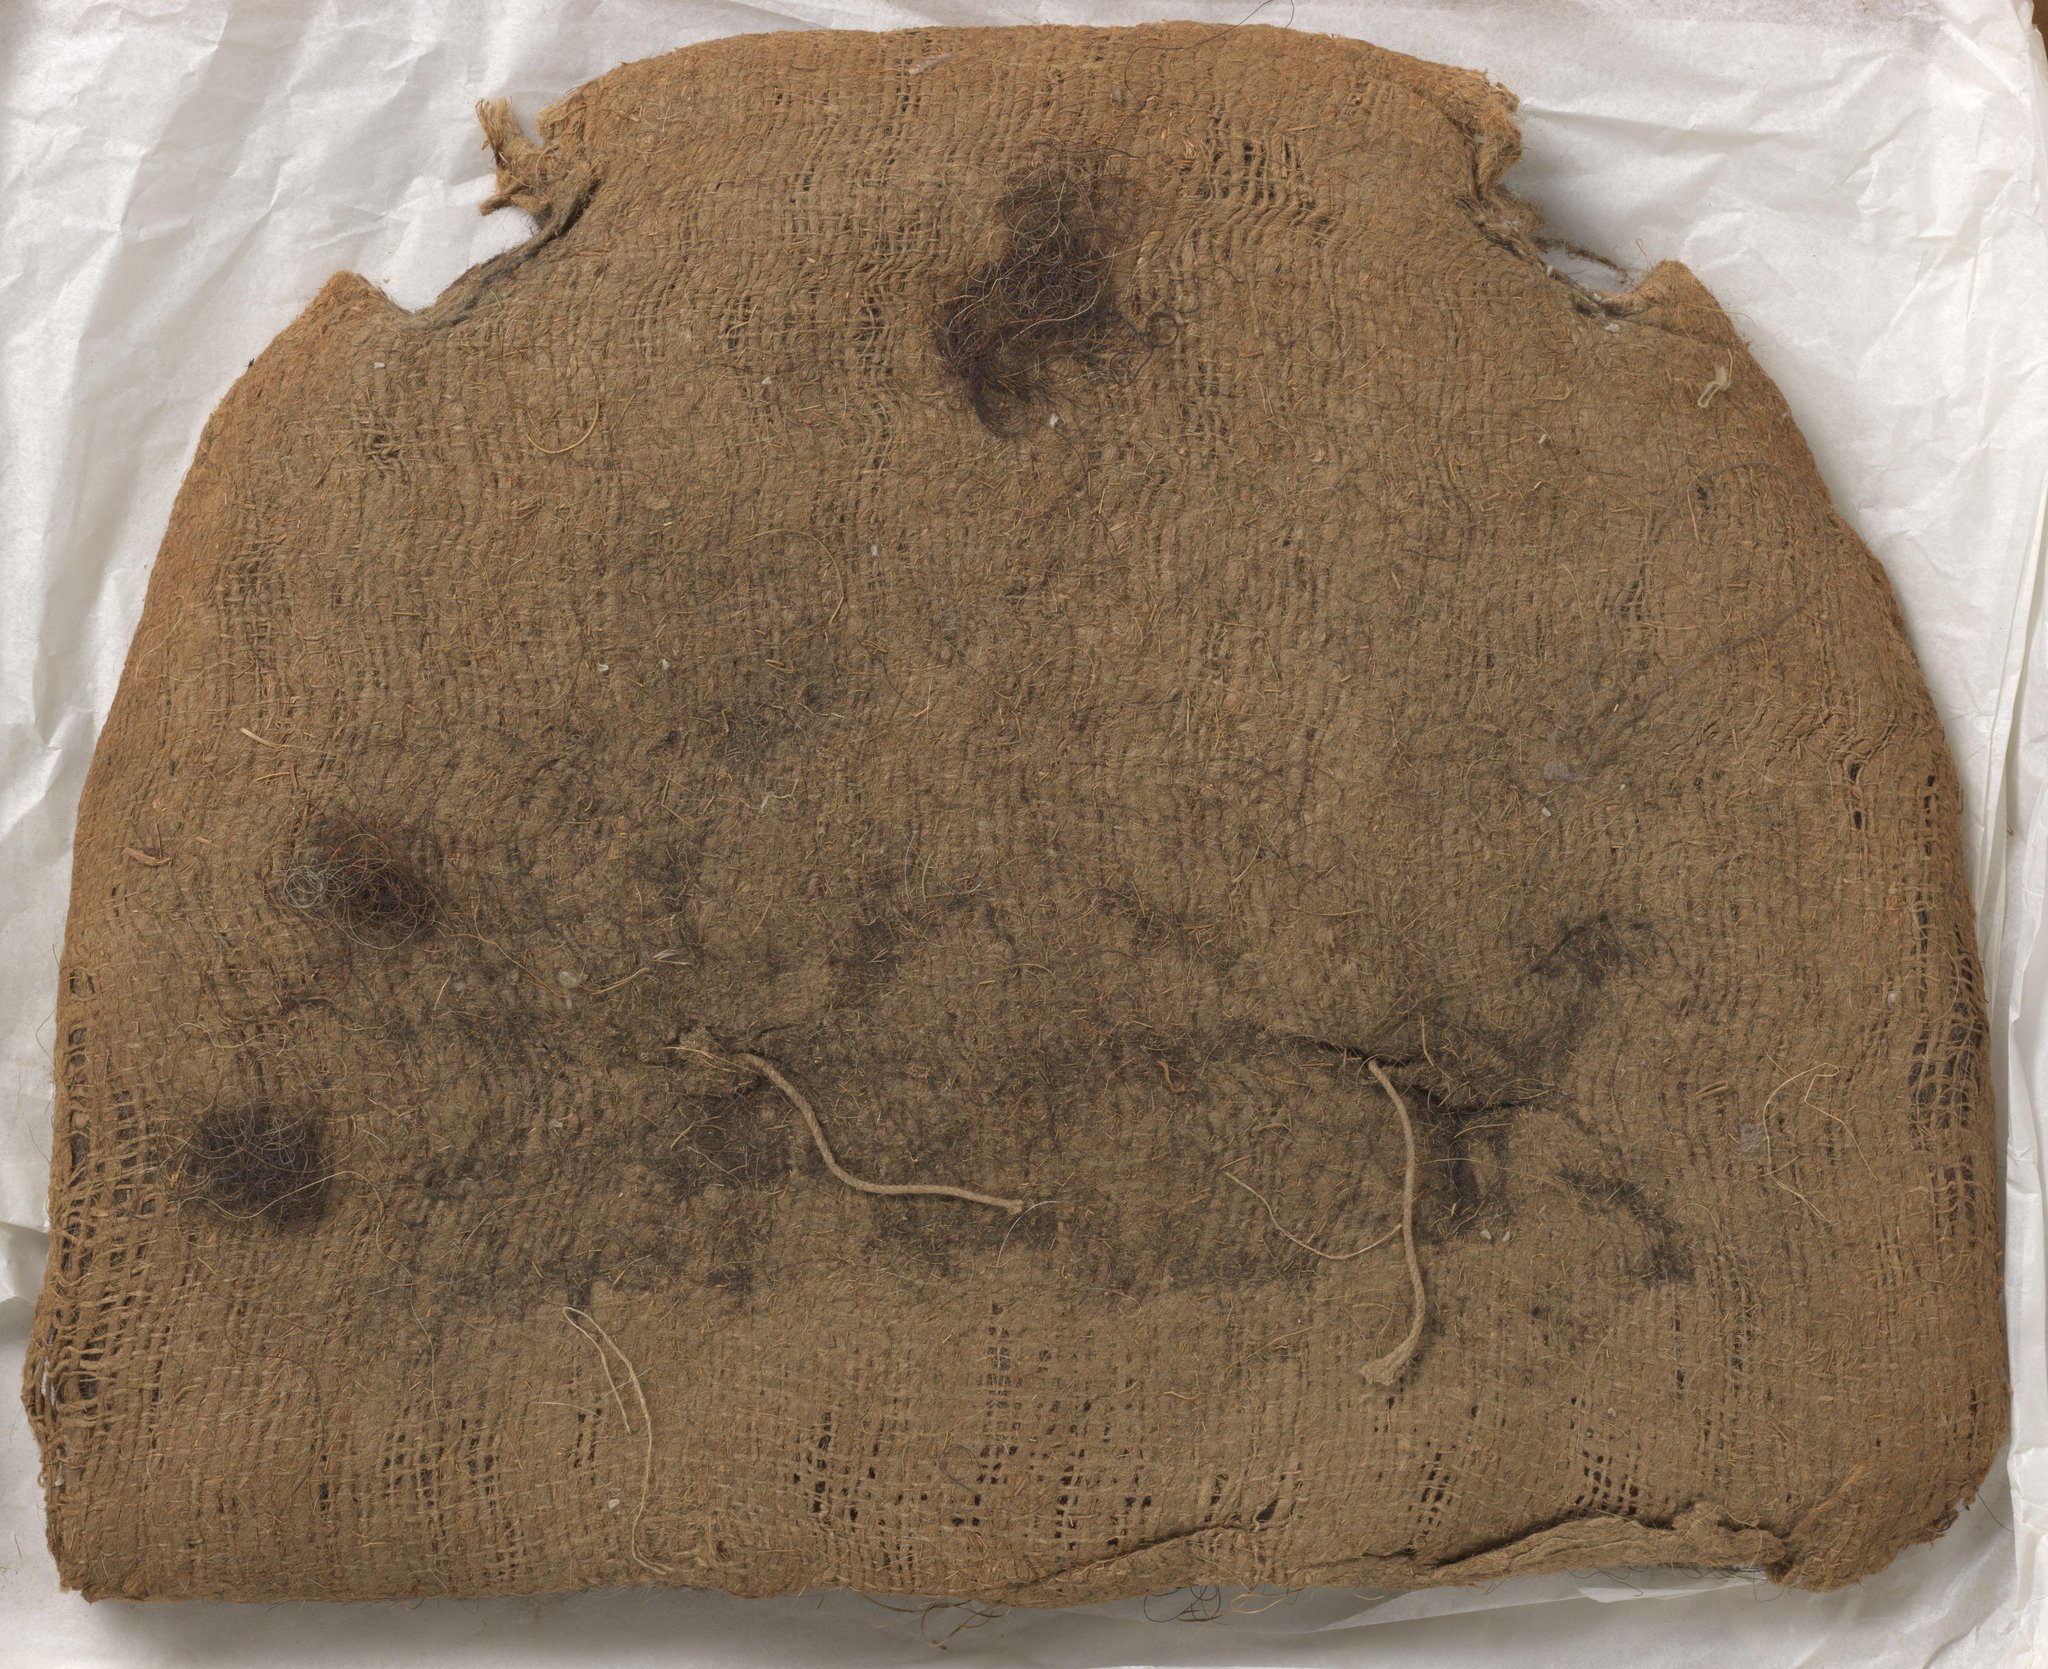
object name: chair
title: Vulling van een stoelbekleding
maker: Anonymous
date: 1785-1800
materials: hair, jute, wool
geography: northern netherlands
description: Vulling van een stoelbekleding. De vulling heeft een afgeronde kant en bestaat uit wol en paardenhaar, bedekt met jute. Behorend bij een stoel van iepenhout met een beklede zitting en rustend op conische, gecanneleerde voorpoten en flauw wijkende achterpoten (BK-1959-117-B).